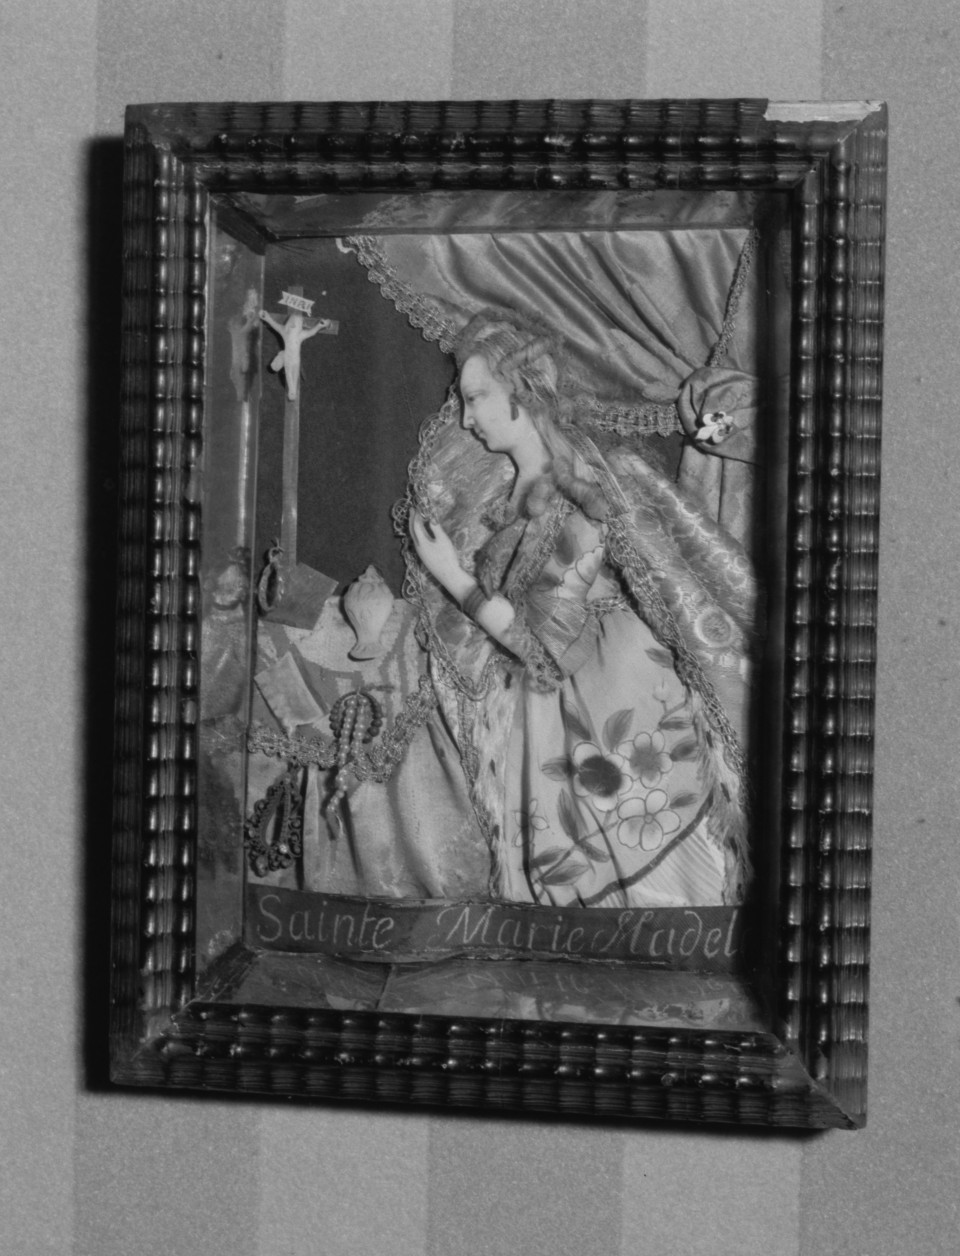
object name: sculpture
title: The Mourning Magdalen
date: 1701-1800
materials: glass, wax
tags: sadness,mary magdalene,cross